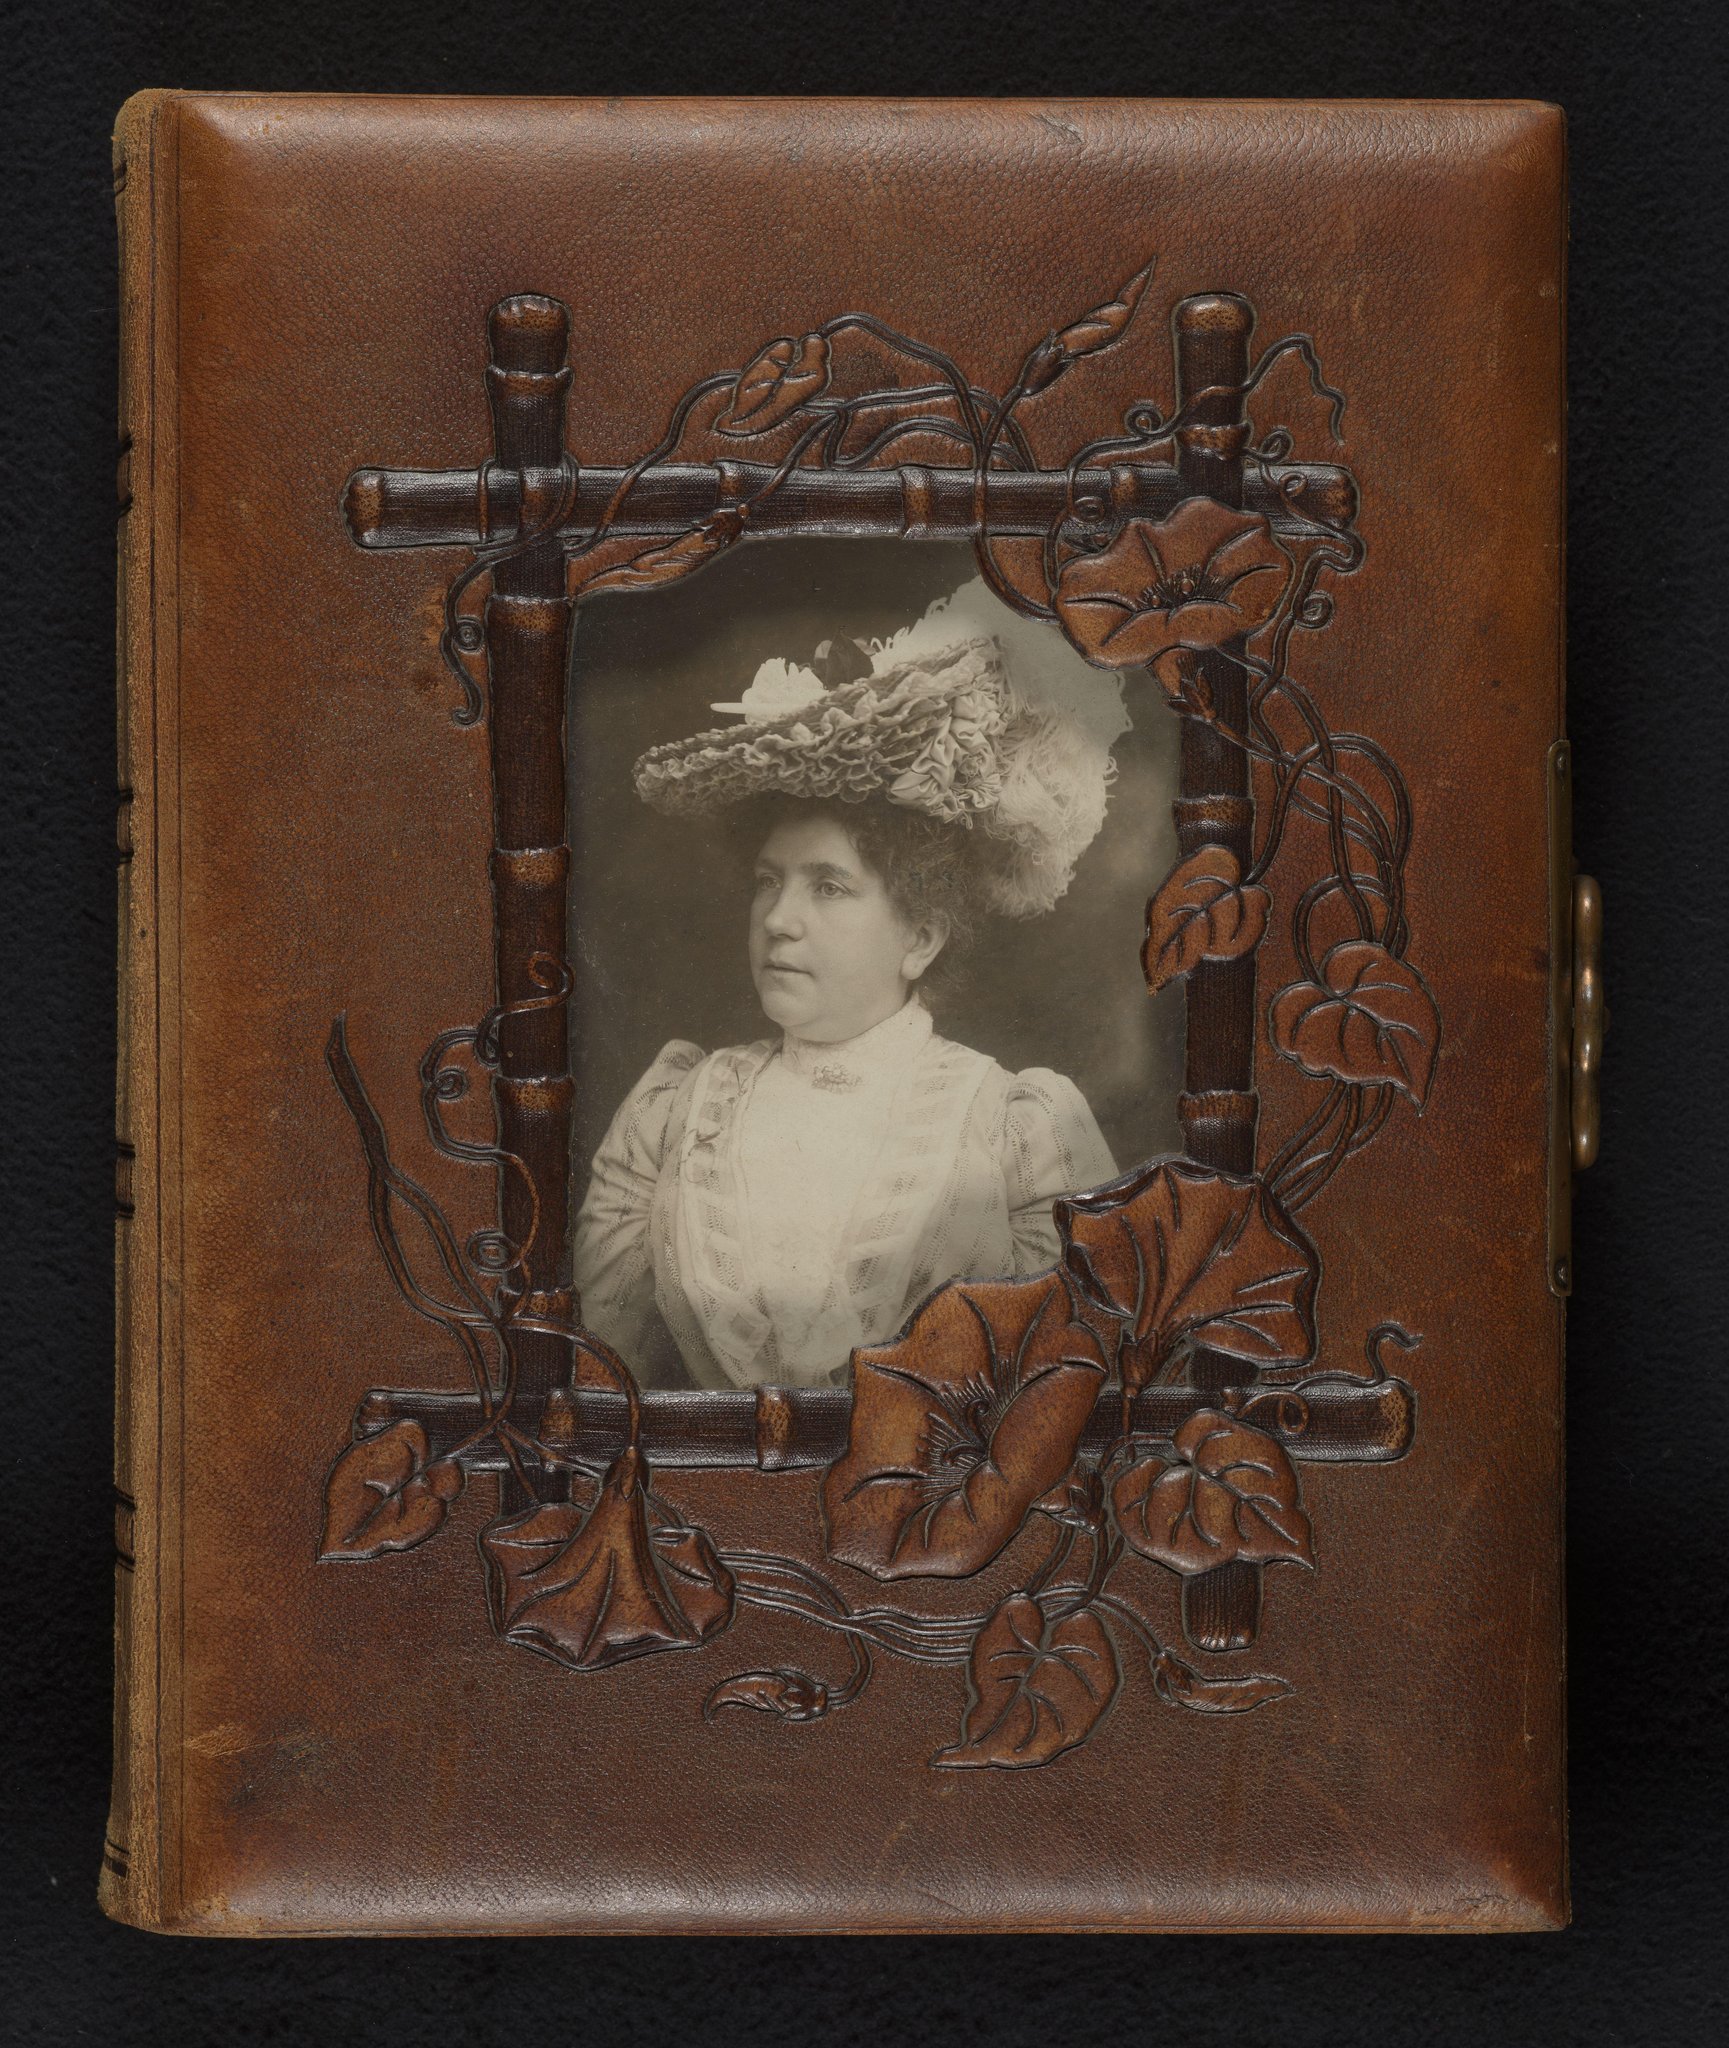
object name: photograph album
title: Nederlands familiealbum met 29 foto's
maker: Anonymous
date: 1860-1920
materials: cardboard, glass, leather, metal, paper, photographic support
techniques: albumen print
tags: square, place, circus, etc., historical persons - bb - woman, historical persons, hospital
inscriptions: collector's mark: ‘DIENST/ VERSPREIDE/ RIJKSKOLLEKTIES/ (...) A 716’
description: Fotoalbum met 40 pagina's met in totaal 29 foto's. Het album bevat 12 kabinetfoto's en 17 cartes-de-visite in met gouden lijnen omkaderde passe-partouts. Afgebeeld zijn portretten van mannen, vrouwen en kinderen, een gezicht op Plein 1813 en een gezicht op de Sophia Stichting in Den Haag en een foto van 6 mensen bij een roeiboot. In het voorplat zit een passe-partout met venster, waarachter een portret van een vrouw met hoed is gestoken. De achternaam Heynen wordt vermeld op de achterzijde van enkele foto's. De foto's zijn gemaakt door verschillende fotografen, waaronder Alphonse Zimmersmans en Heinrich Wolfgang Wollrabe. Van 3 foto's is de fotograaf anoniem.